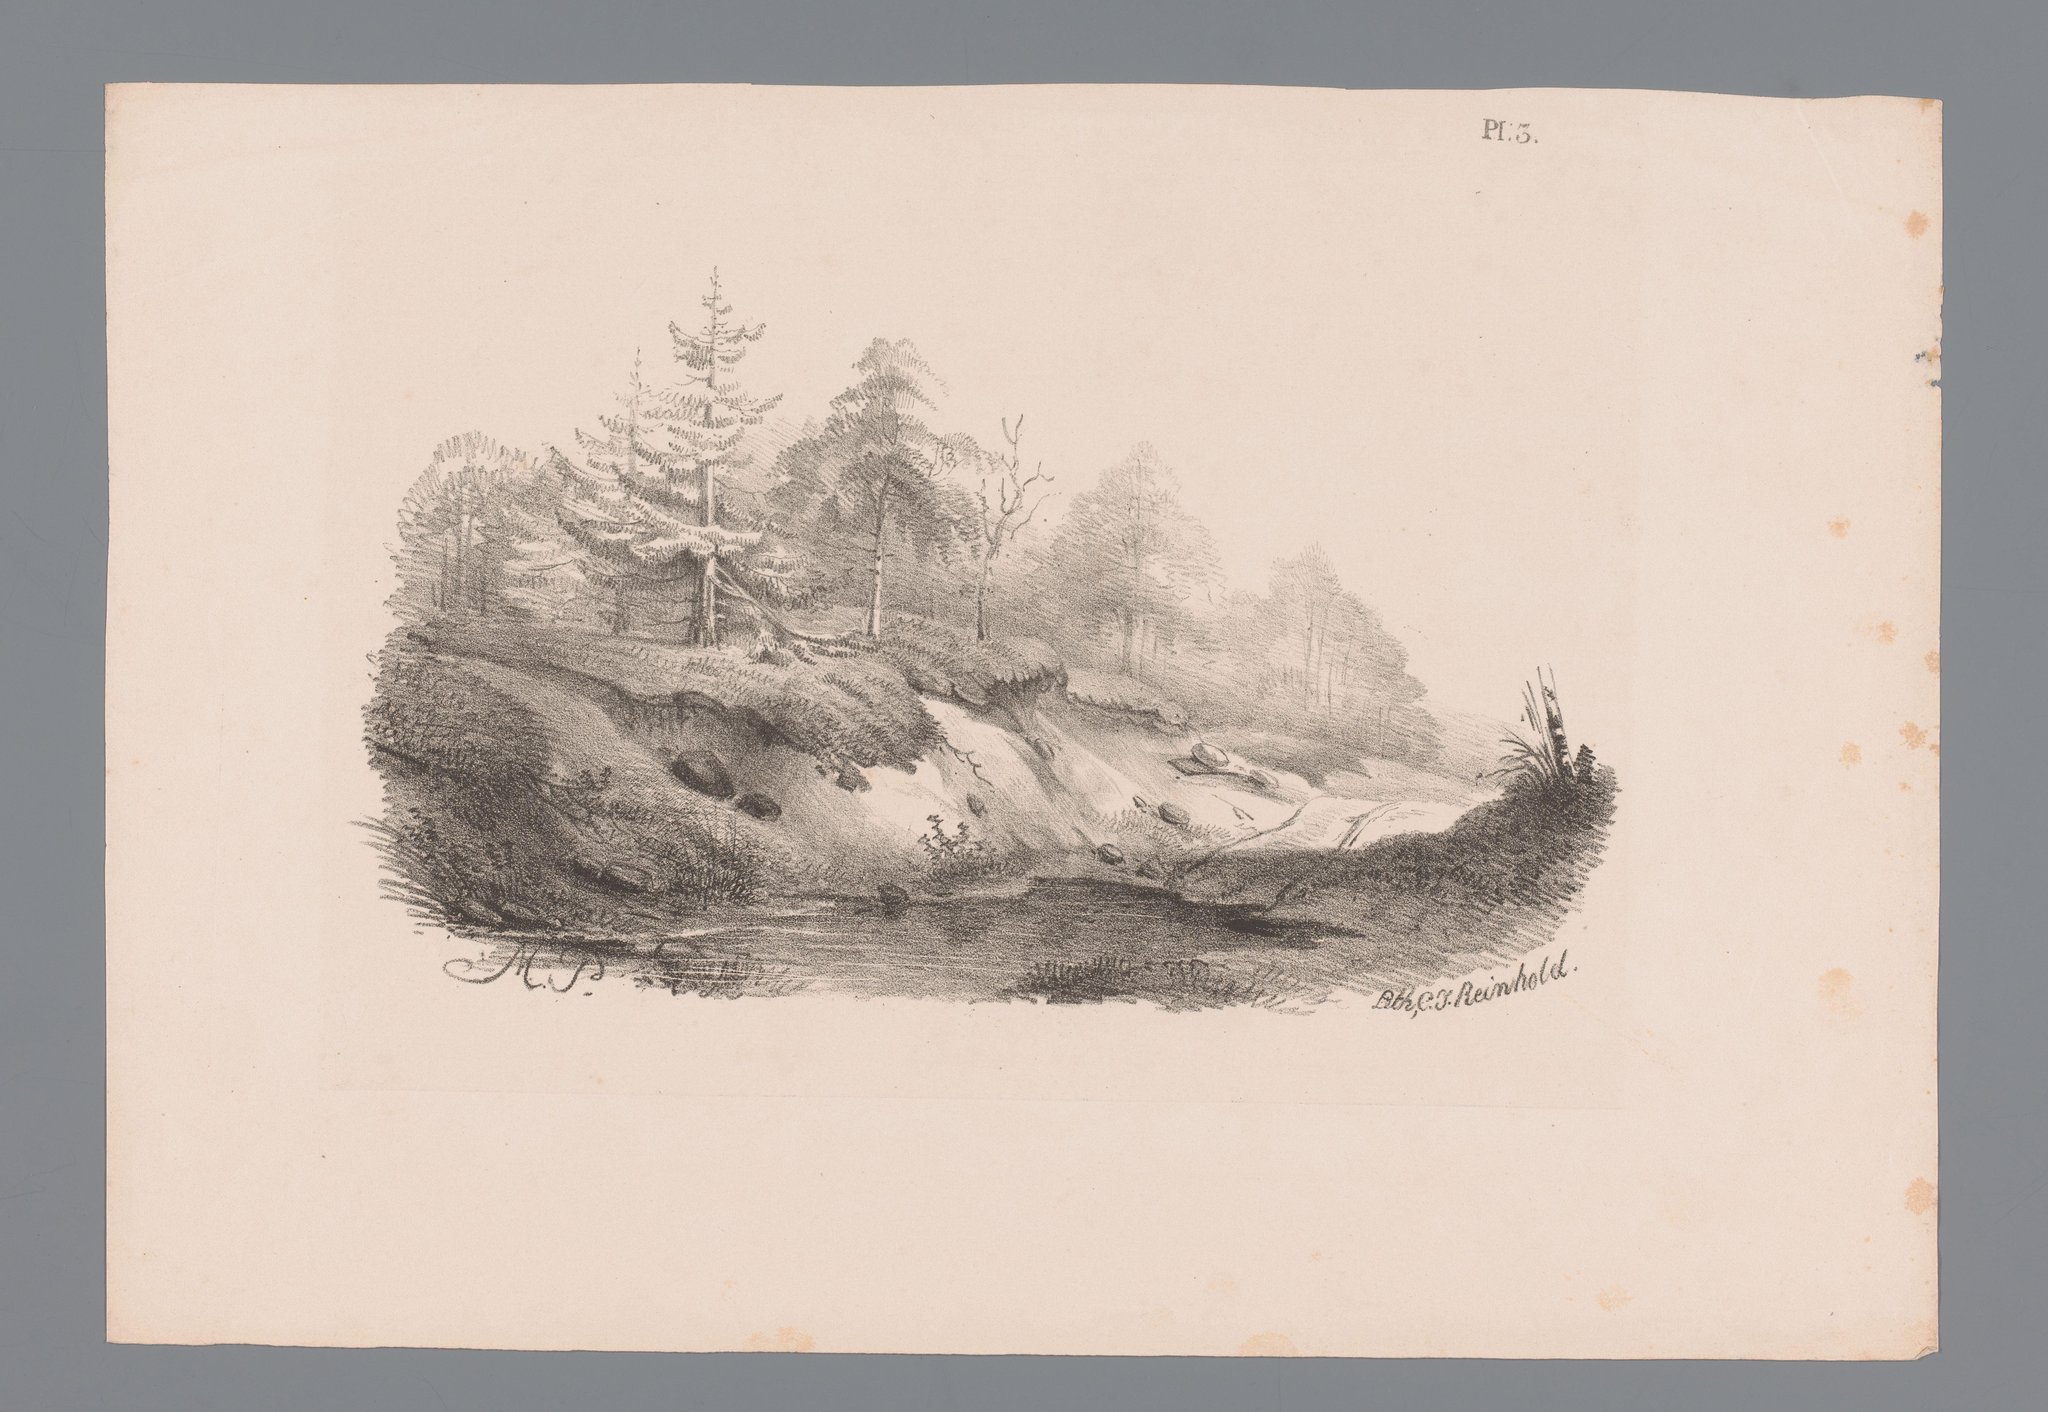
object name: print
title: Geldersche landschap Studien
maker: christiaan johannes reinhold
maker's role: steendrukker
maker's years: 1810-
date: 1838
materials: paper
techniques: lithograph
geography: amsterdam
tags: landscapes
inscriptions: collector's mark: Lugt 2228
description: Een landschap met naaldbomen en een pad dat naar een plas leidt. Onderdeel van een omslag met een serie van vier Gelderse landschappen.